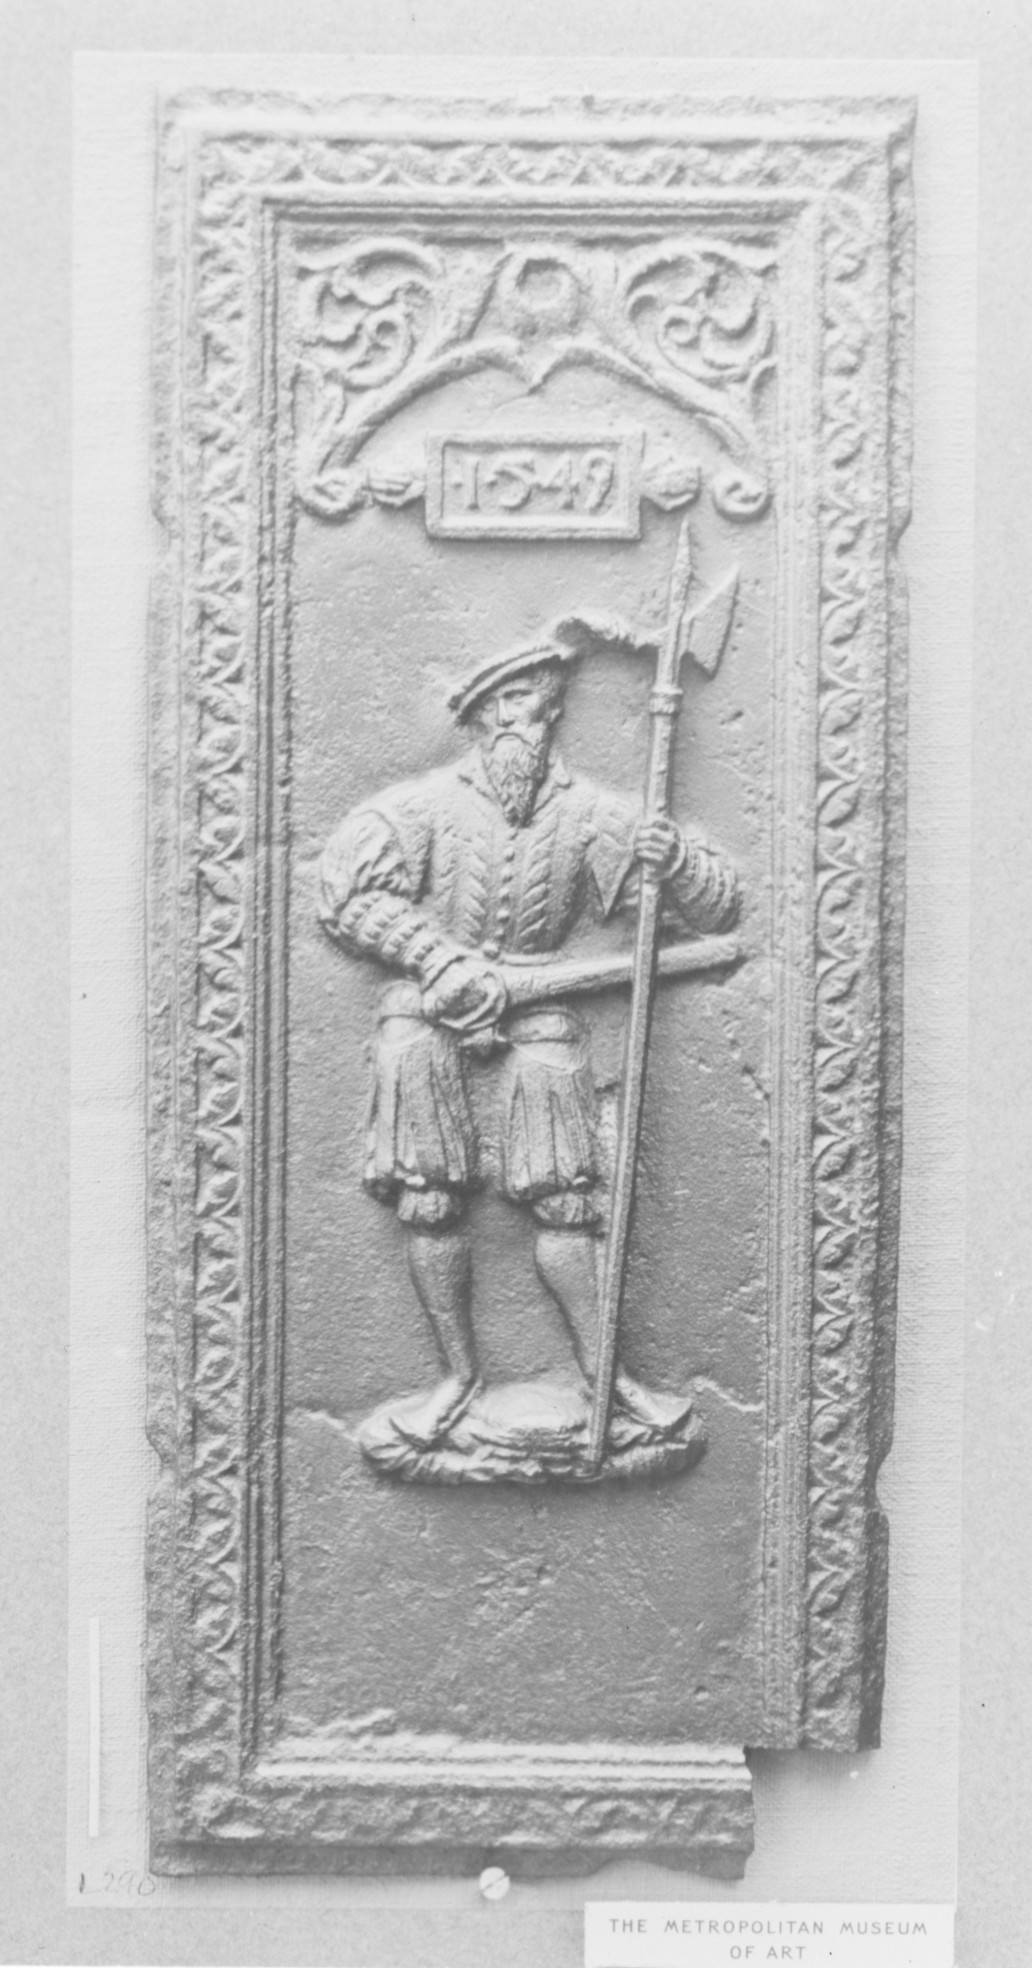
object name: stove plate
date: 1501-1600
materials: iron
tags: men